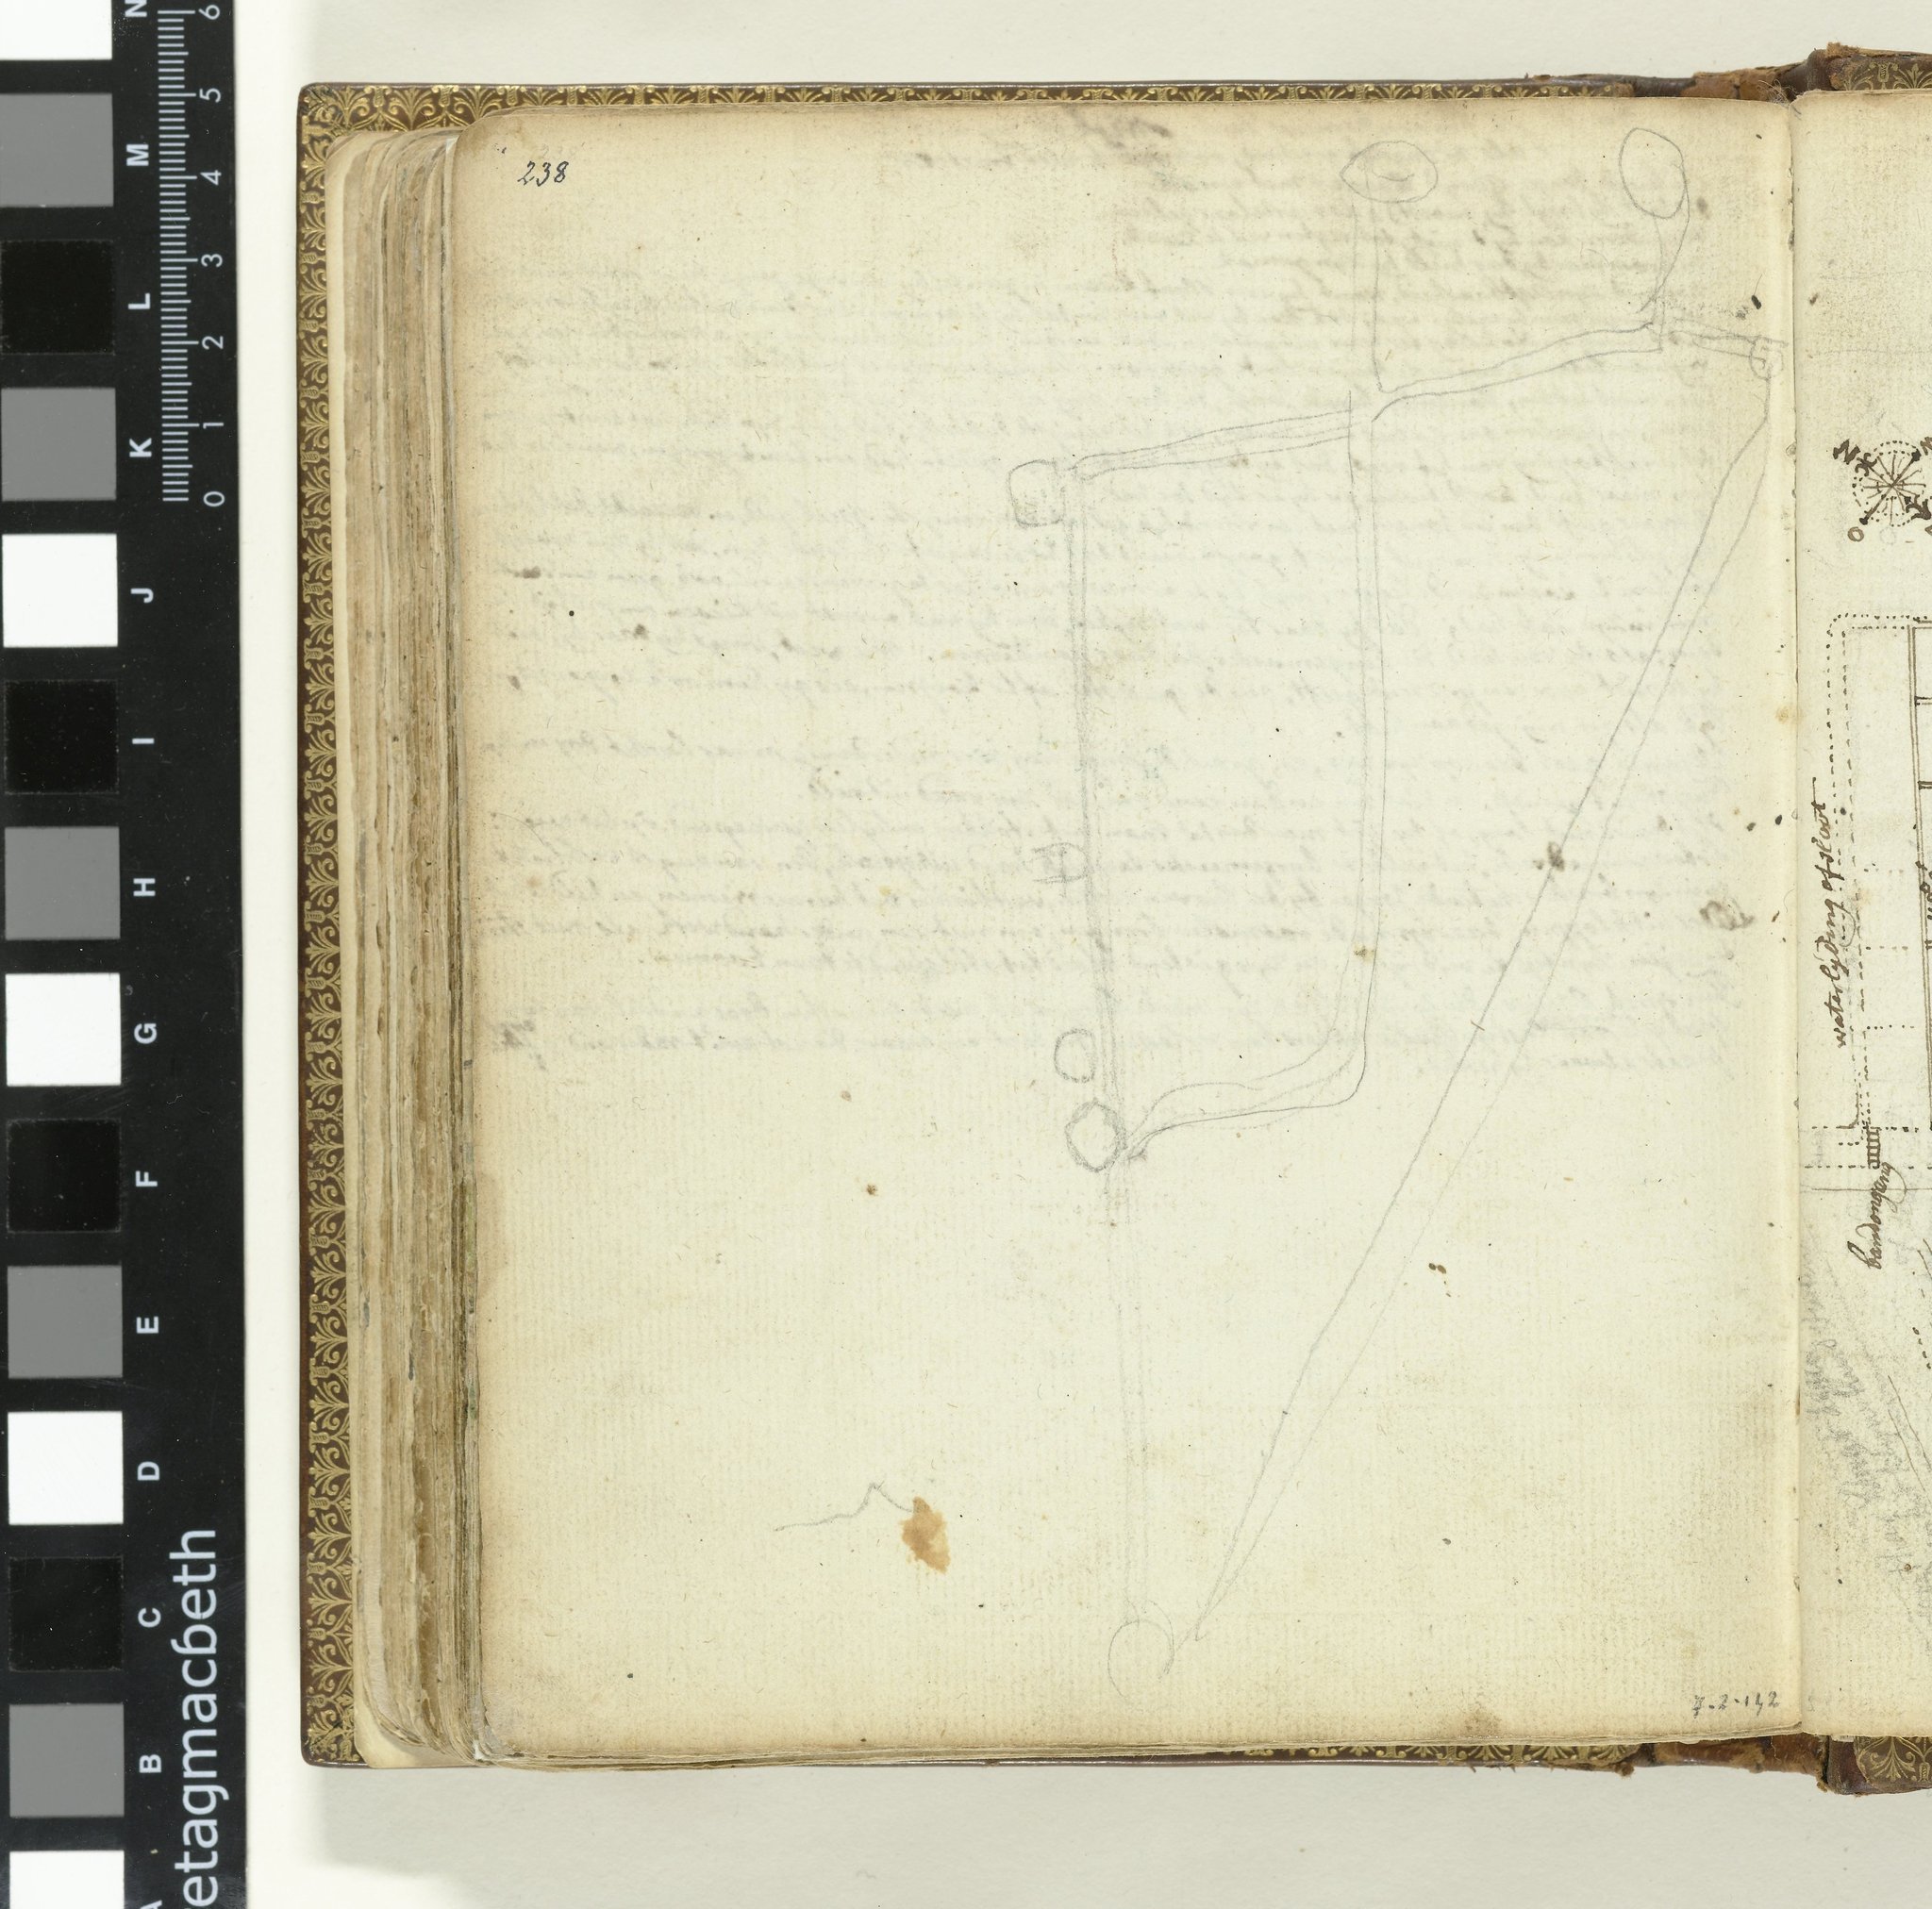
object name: drawing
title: Schets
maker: jan brandes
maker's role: draughtsman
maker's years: 1743-1808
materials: paper, pencil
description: Schets van iets wat tuig zou kunnen zijn van een rijtuig. Zie deel 2, pp. 49, 50. Onderdeel uit het schetsboek van Jan Brandes, dl. 2 (1808), p. 238.